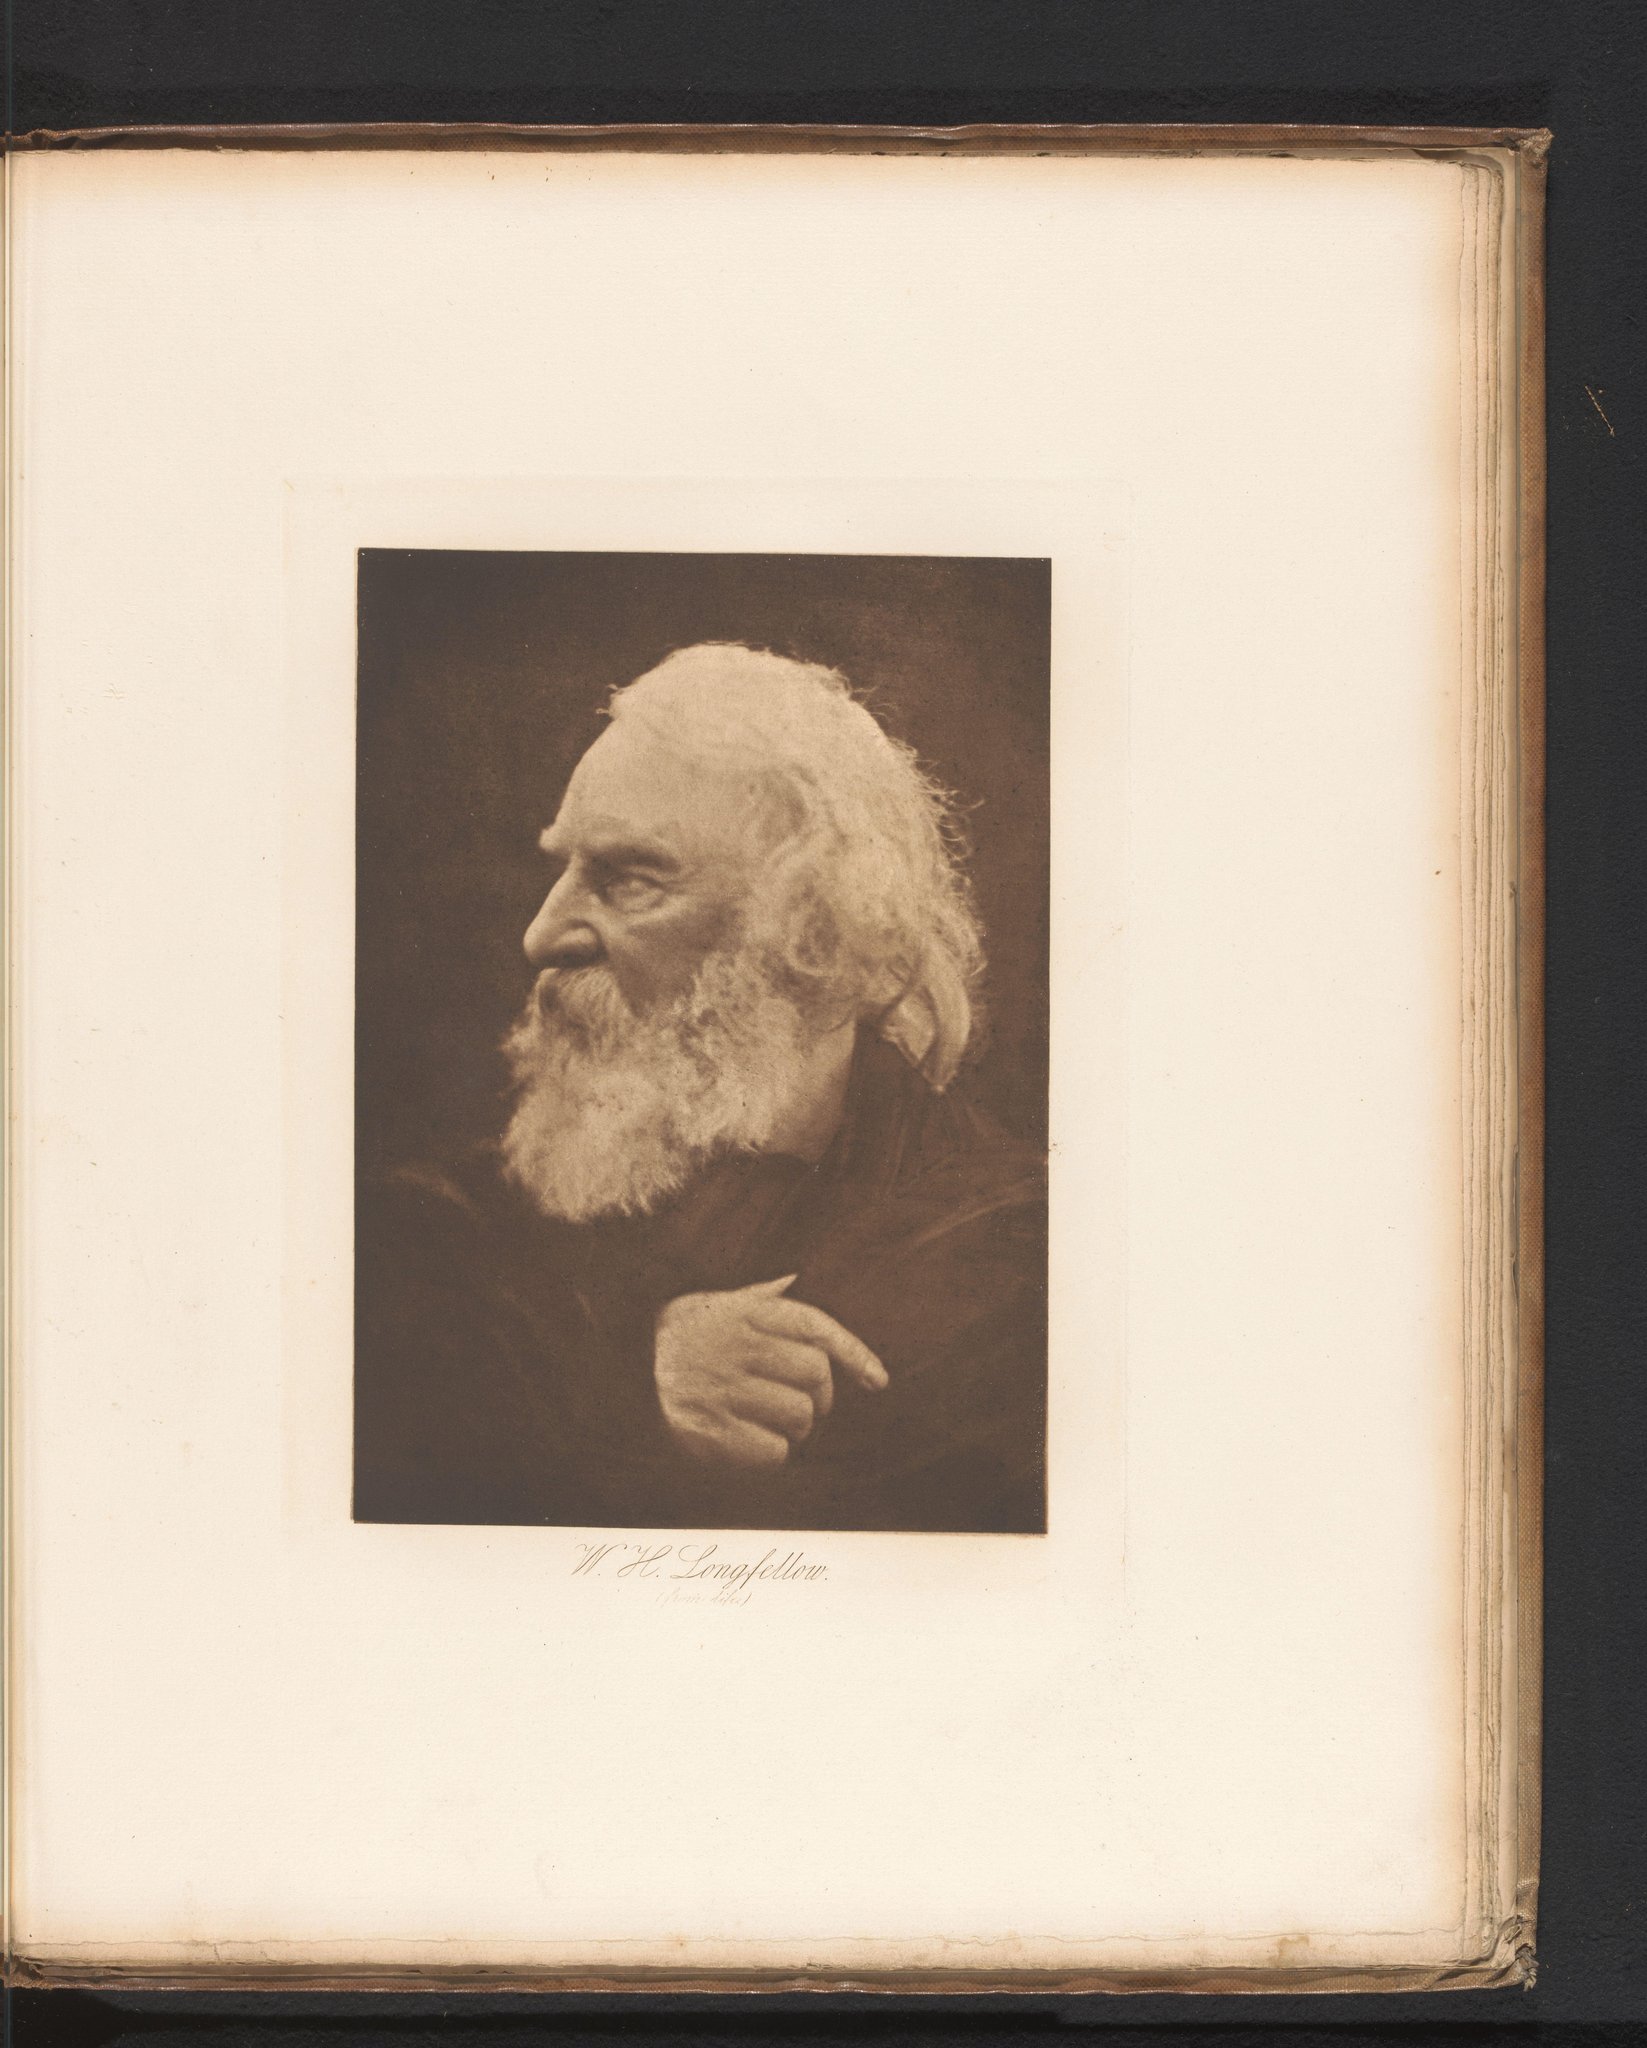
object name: page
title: W. H. Longfellow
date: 1868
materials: paper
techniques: photoaquatint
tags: henry wadsworth longfellow, historical persons, portrait of a writer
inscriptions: inscription: ‘W. H. Longfellow./ (from life.)’